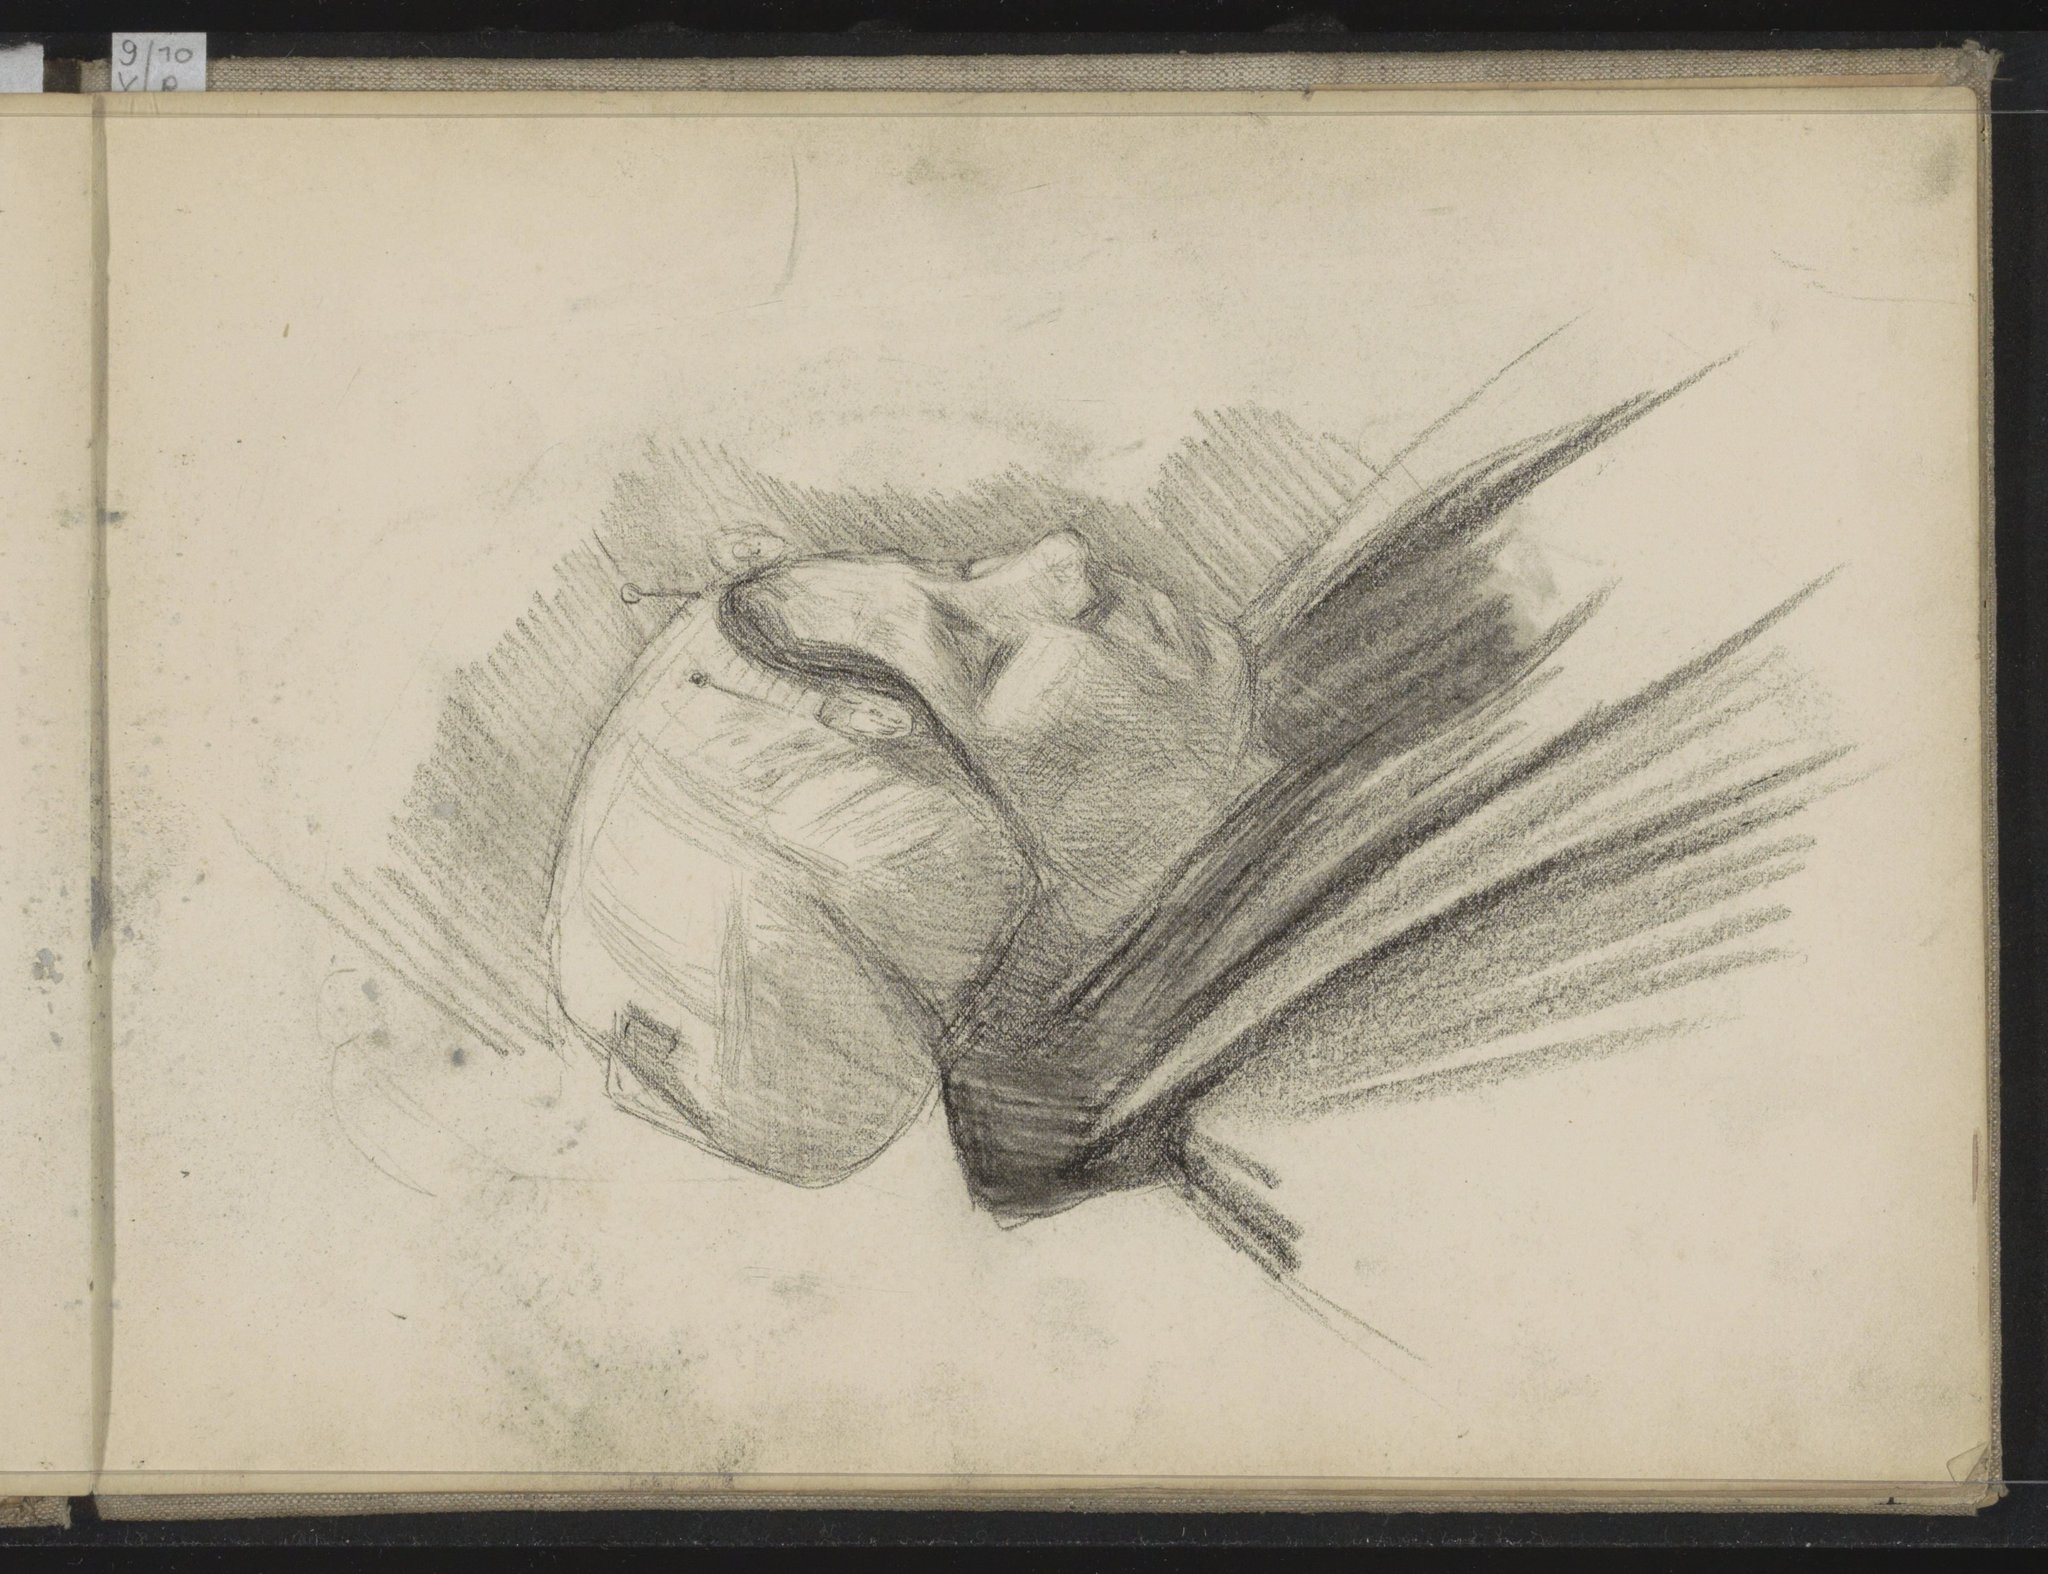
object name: sketchbook leaf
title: Vrouw met een muts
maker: johanna van de kamer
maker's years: 1873-1922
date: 1890-1922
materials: chalk, paper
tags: head-gear: cap (+ women's clothes), folk costume, regional costume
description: Blad 6 recto uit een schetsboek met 11 bladen.